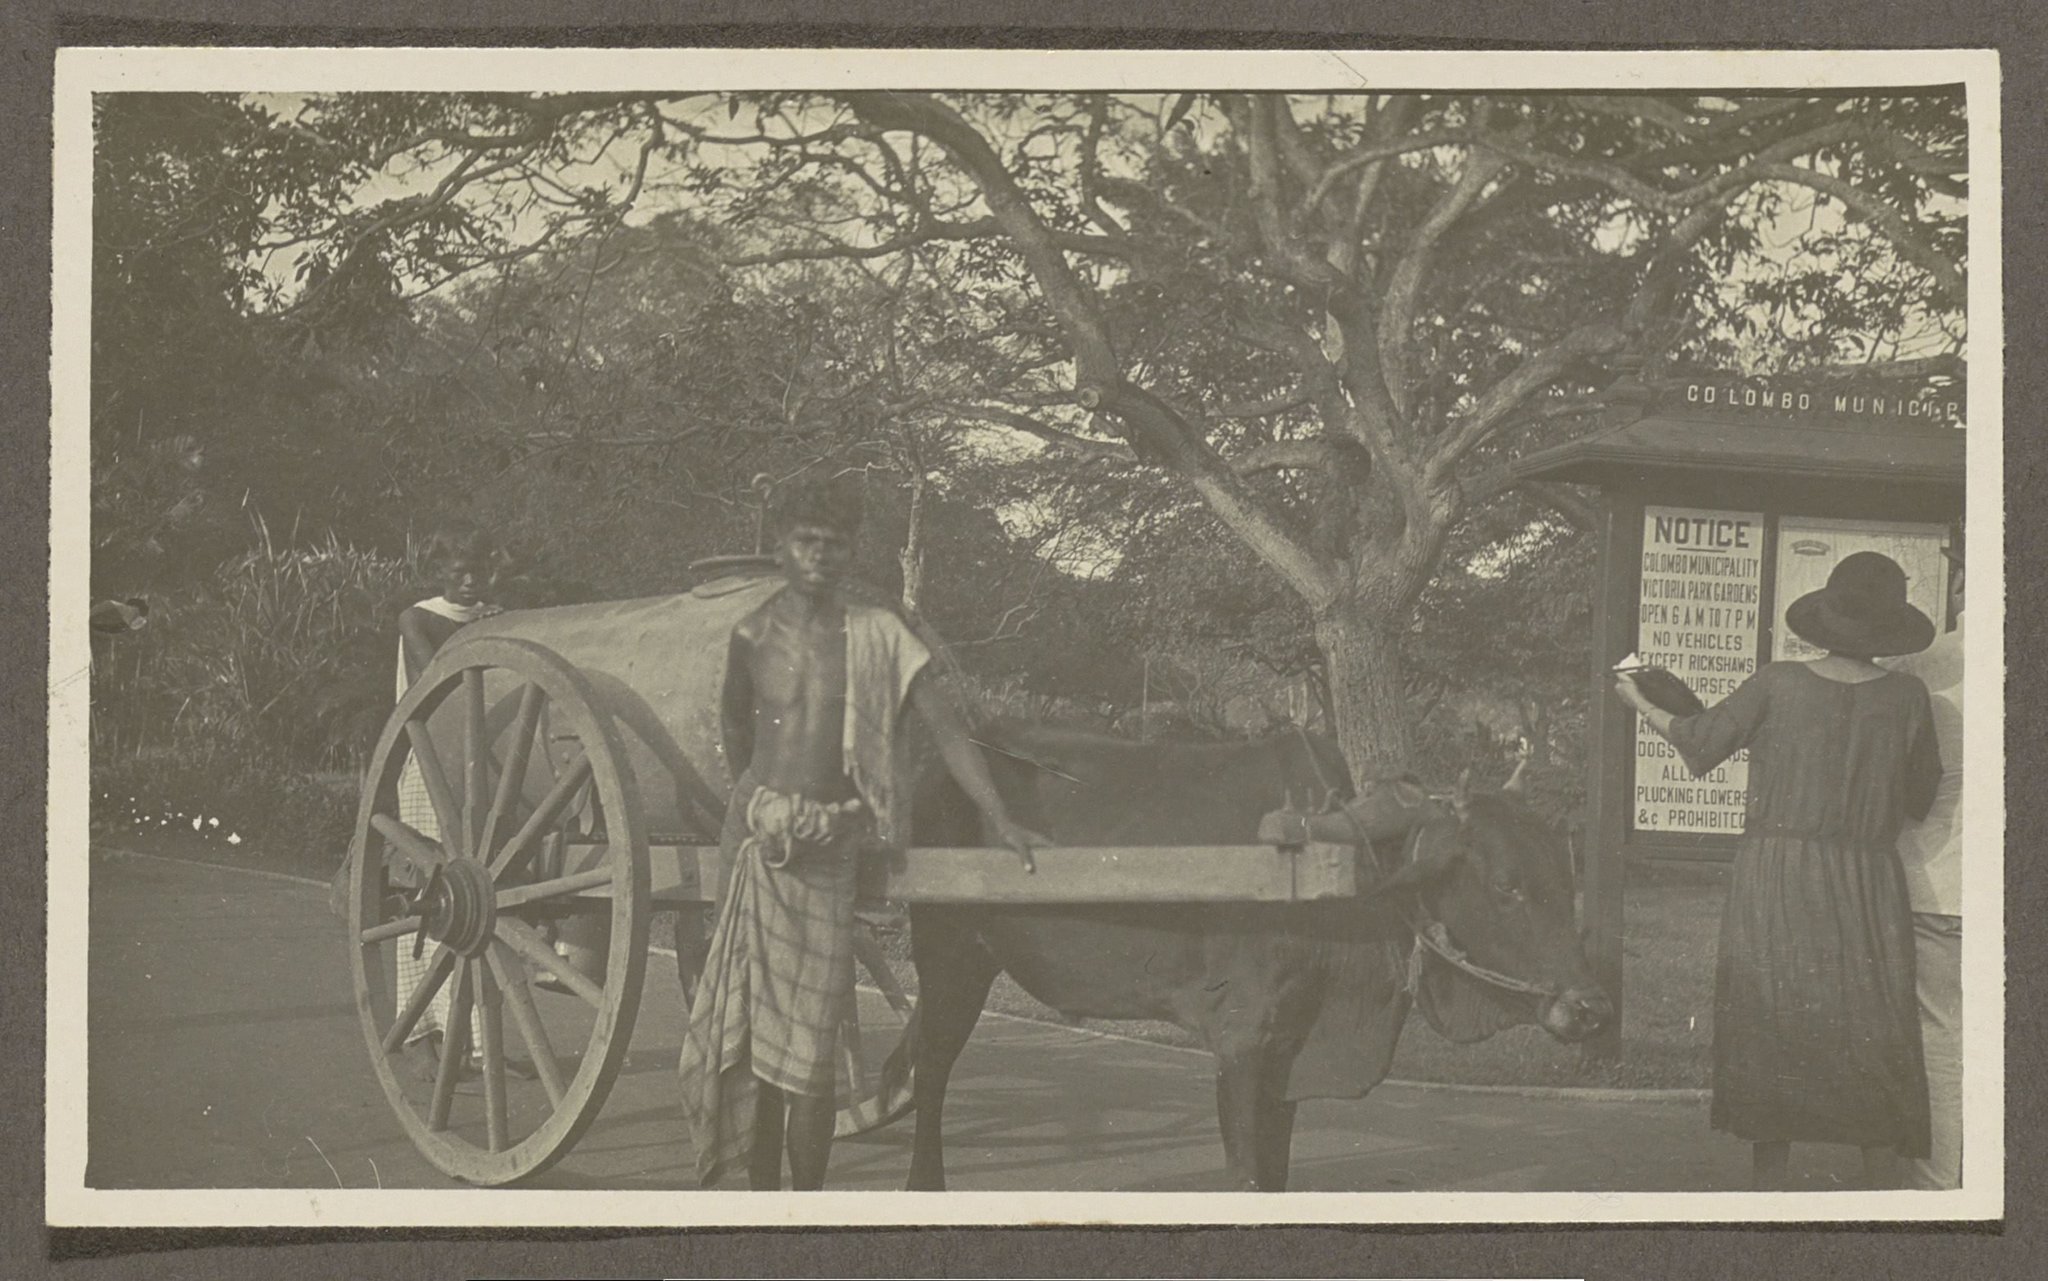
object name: photograph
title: Twee jongens met een ossenwagen, rechts een vrouw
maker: Anonymous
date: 1920-1930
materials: photographic support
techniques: gelatin silver print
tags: animal traction, animal-drawn vehicle (carriage etc.), public gardens, park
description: Twee jongens poseren bij een met een vat geladen ossenwagen. Rechts een vrouw die de regels geldend in de Victoria Park Gardens in de stad Colombo leest. Onderdeel van familiealbum Nederlands-Indië.